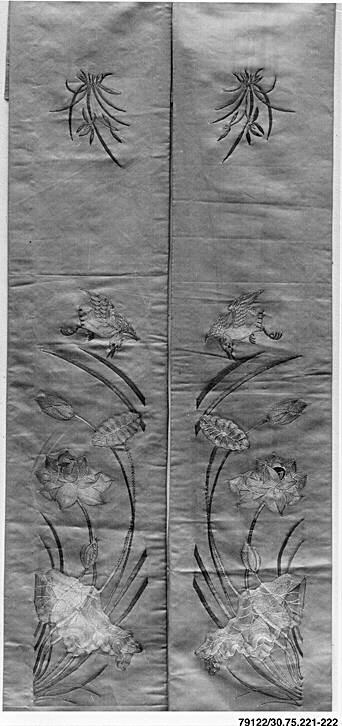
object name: sleeve band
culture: chinese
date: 1801-1900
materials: metal thread, silk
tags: birds,lotuses